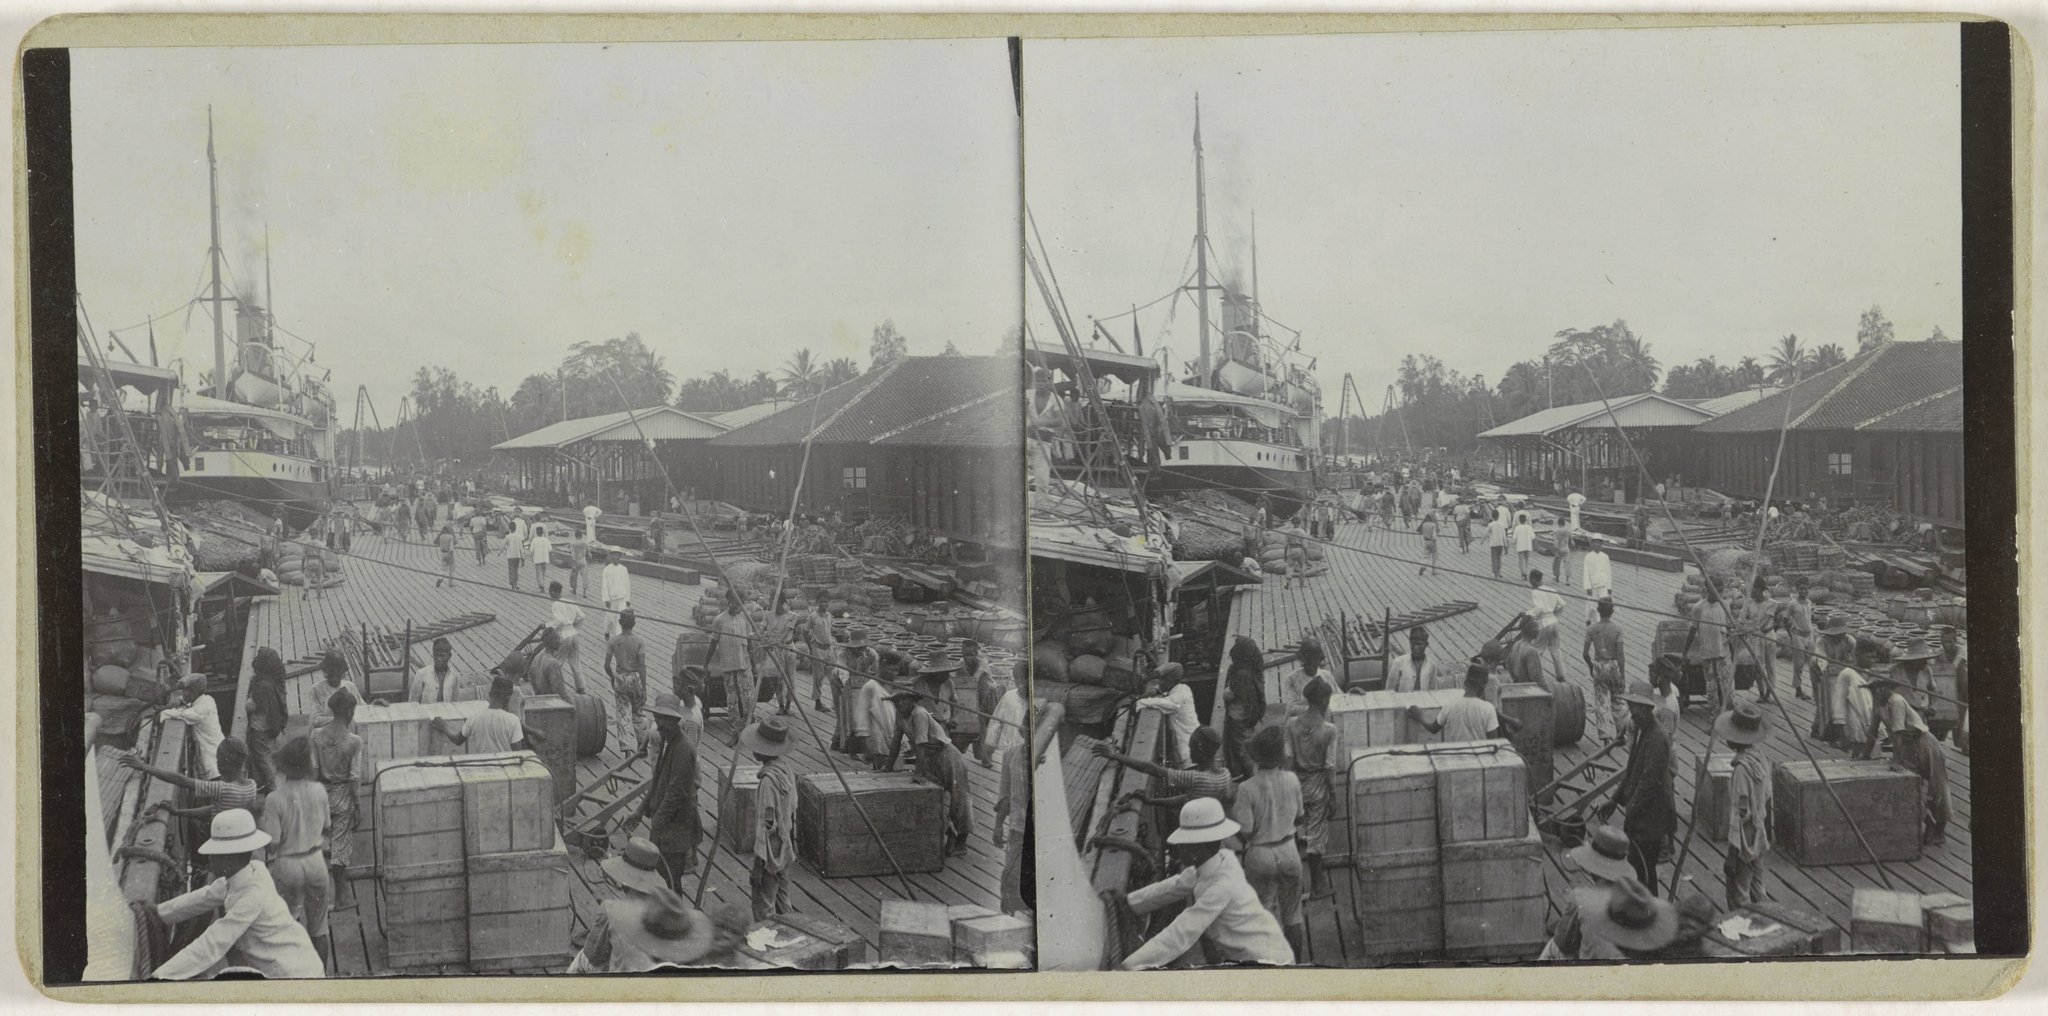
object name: stereograph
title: Gezicht op een haven in Indonesië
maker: Anonymous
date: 1890-1930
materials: paper, cardboard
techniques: gelatin silver print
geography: indonesia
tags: harbour, indonesia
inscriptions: inscription: ‘B' Massin’